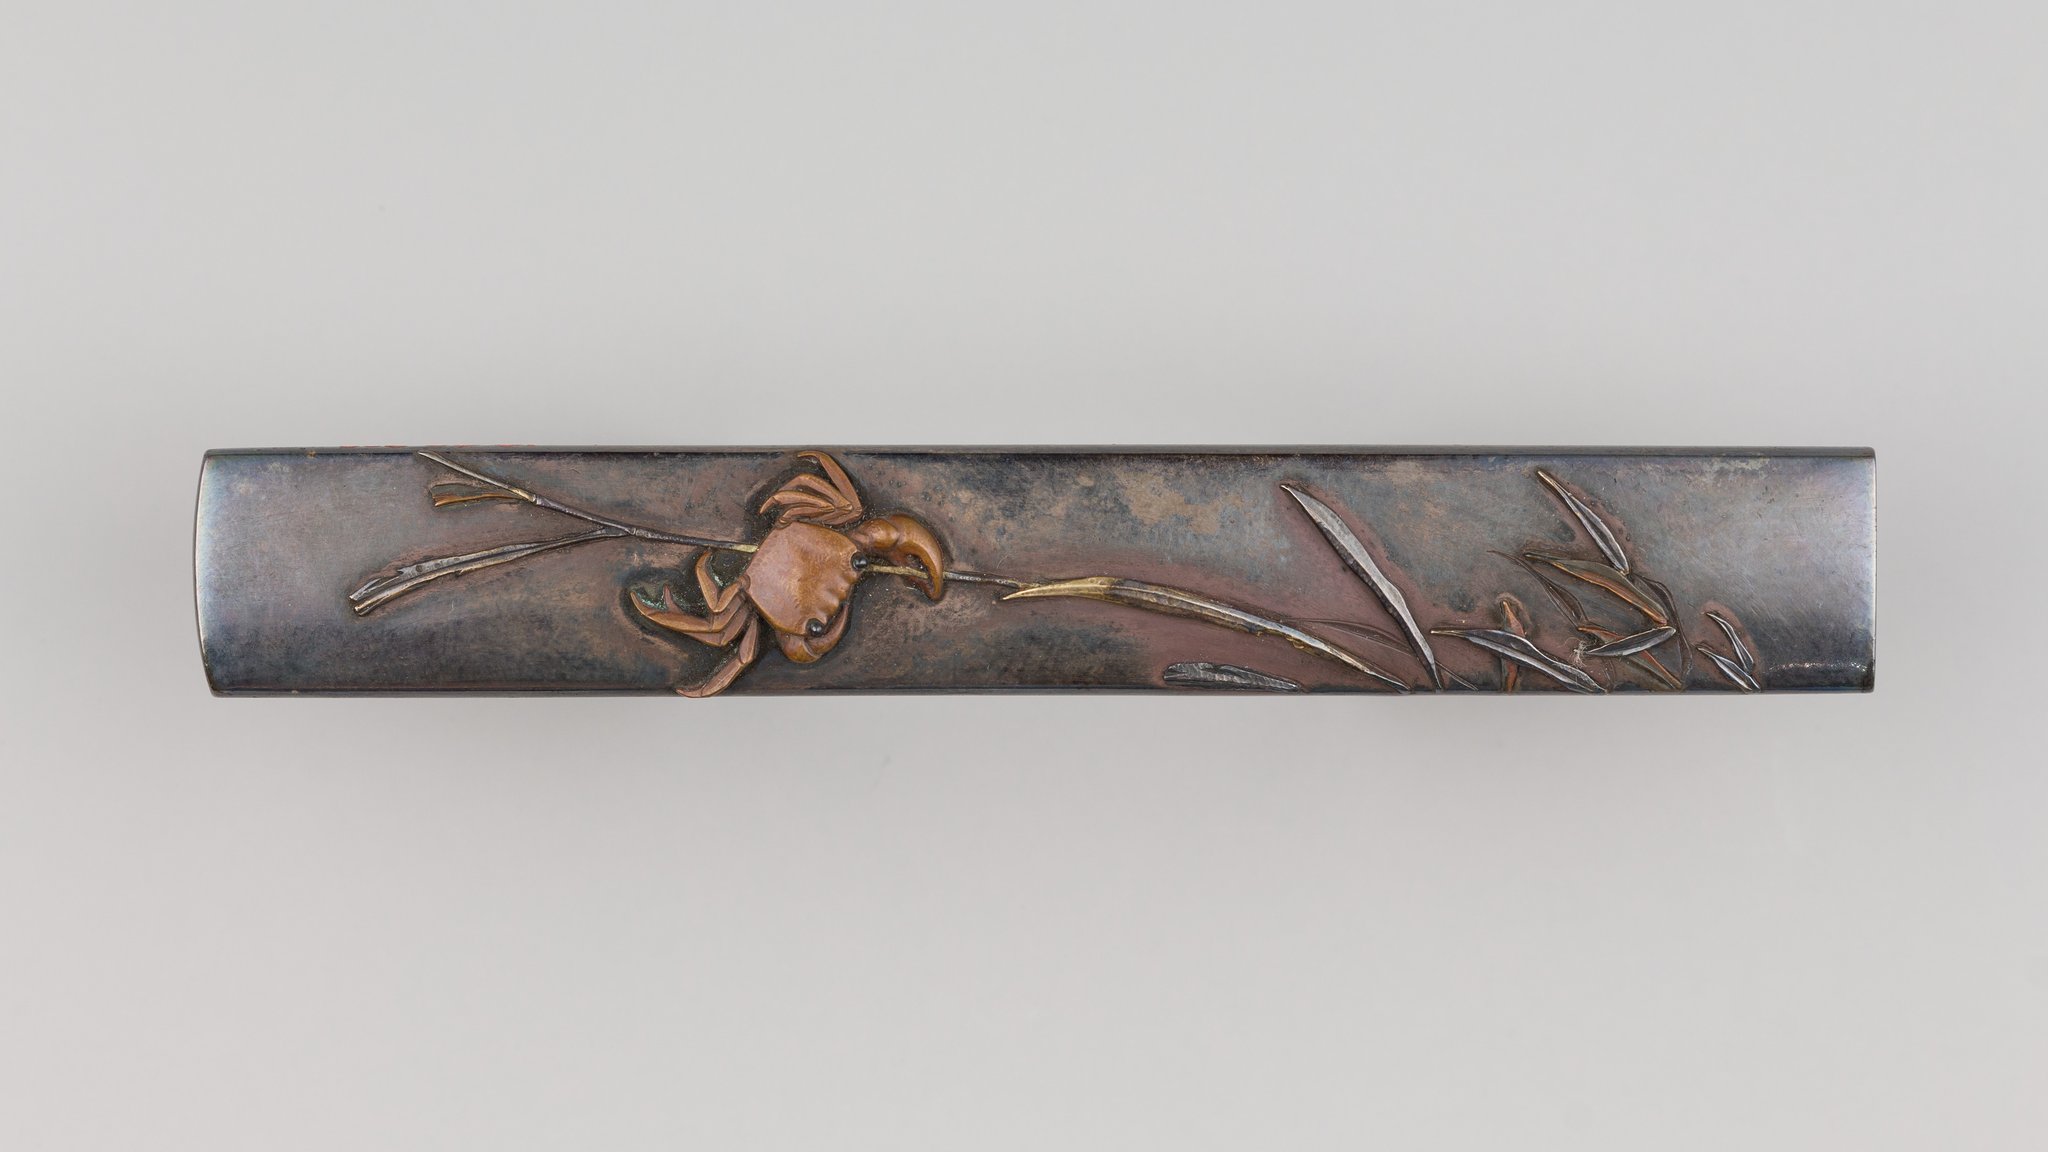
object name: knife handle kozuka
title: Knife Handle (Kozuka)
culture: japanese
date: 1801-1900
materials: copper, silver alloy, gold, silver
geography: japan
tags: crabs